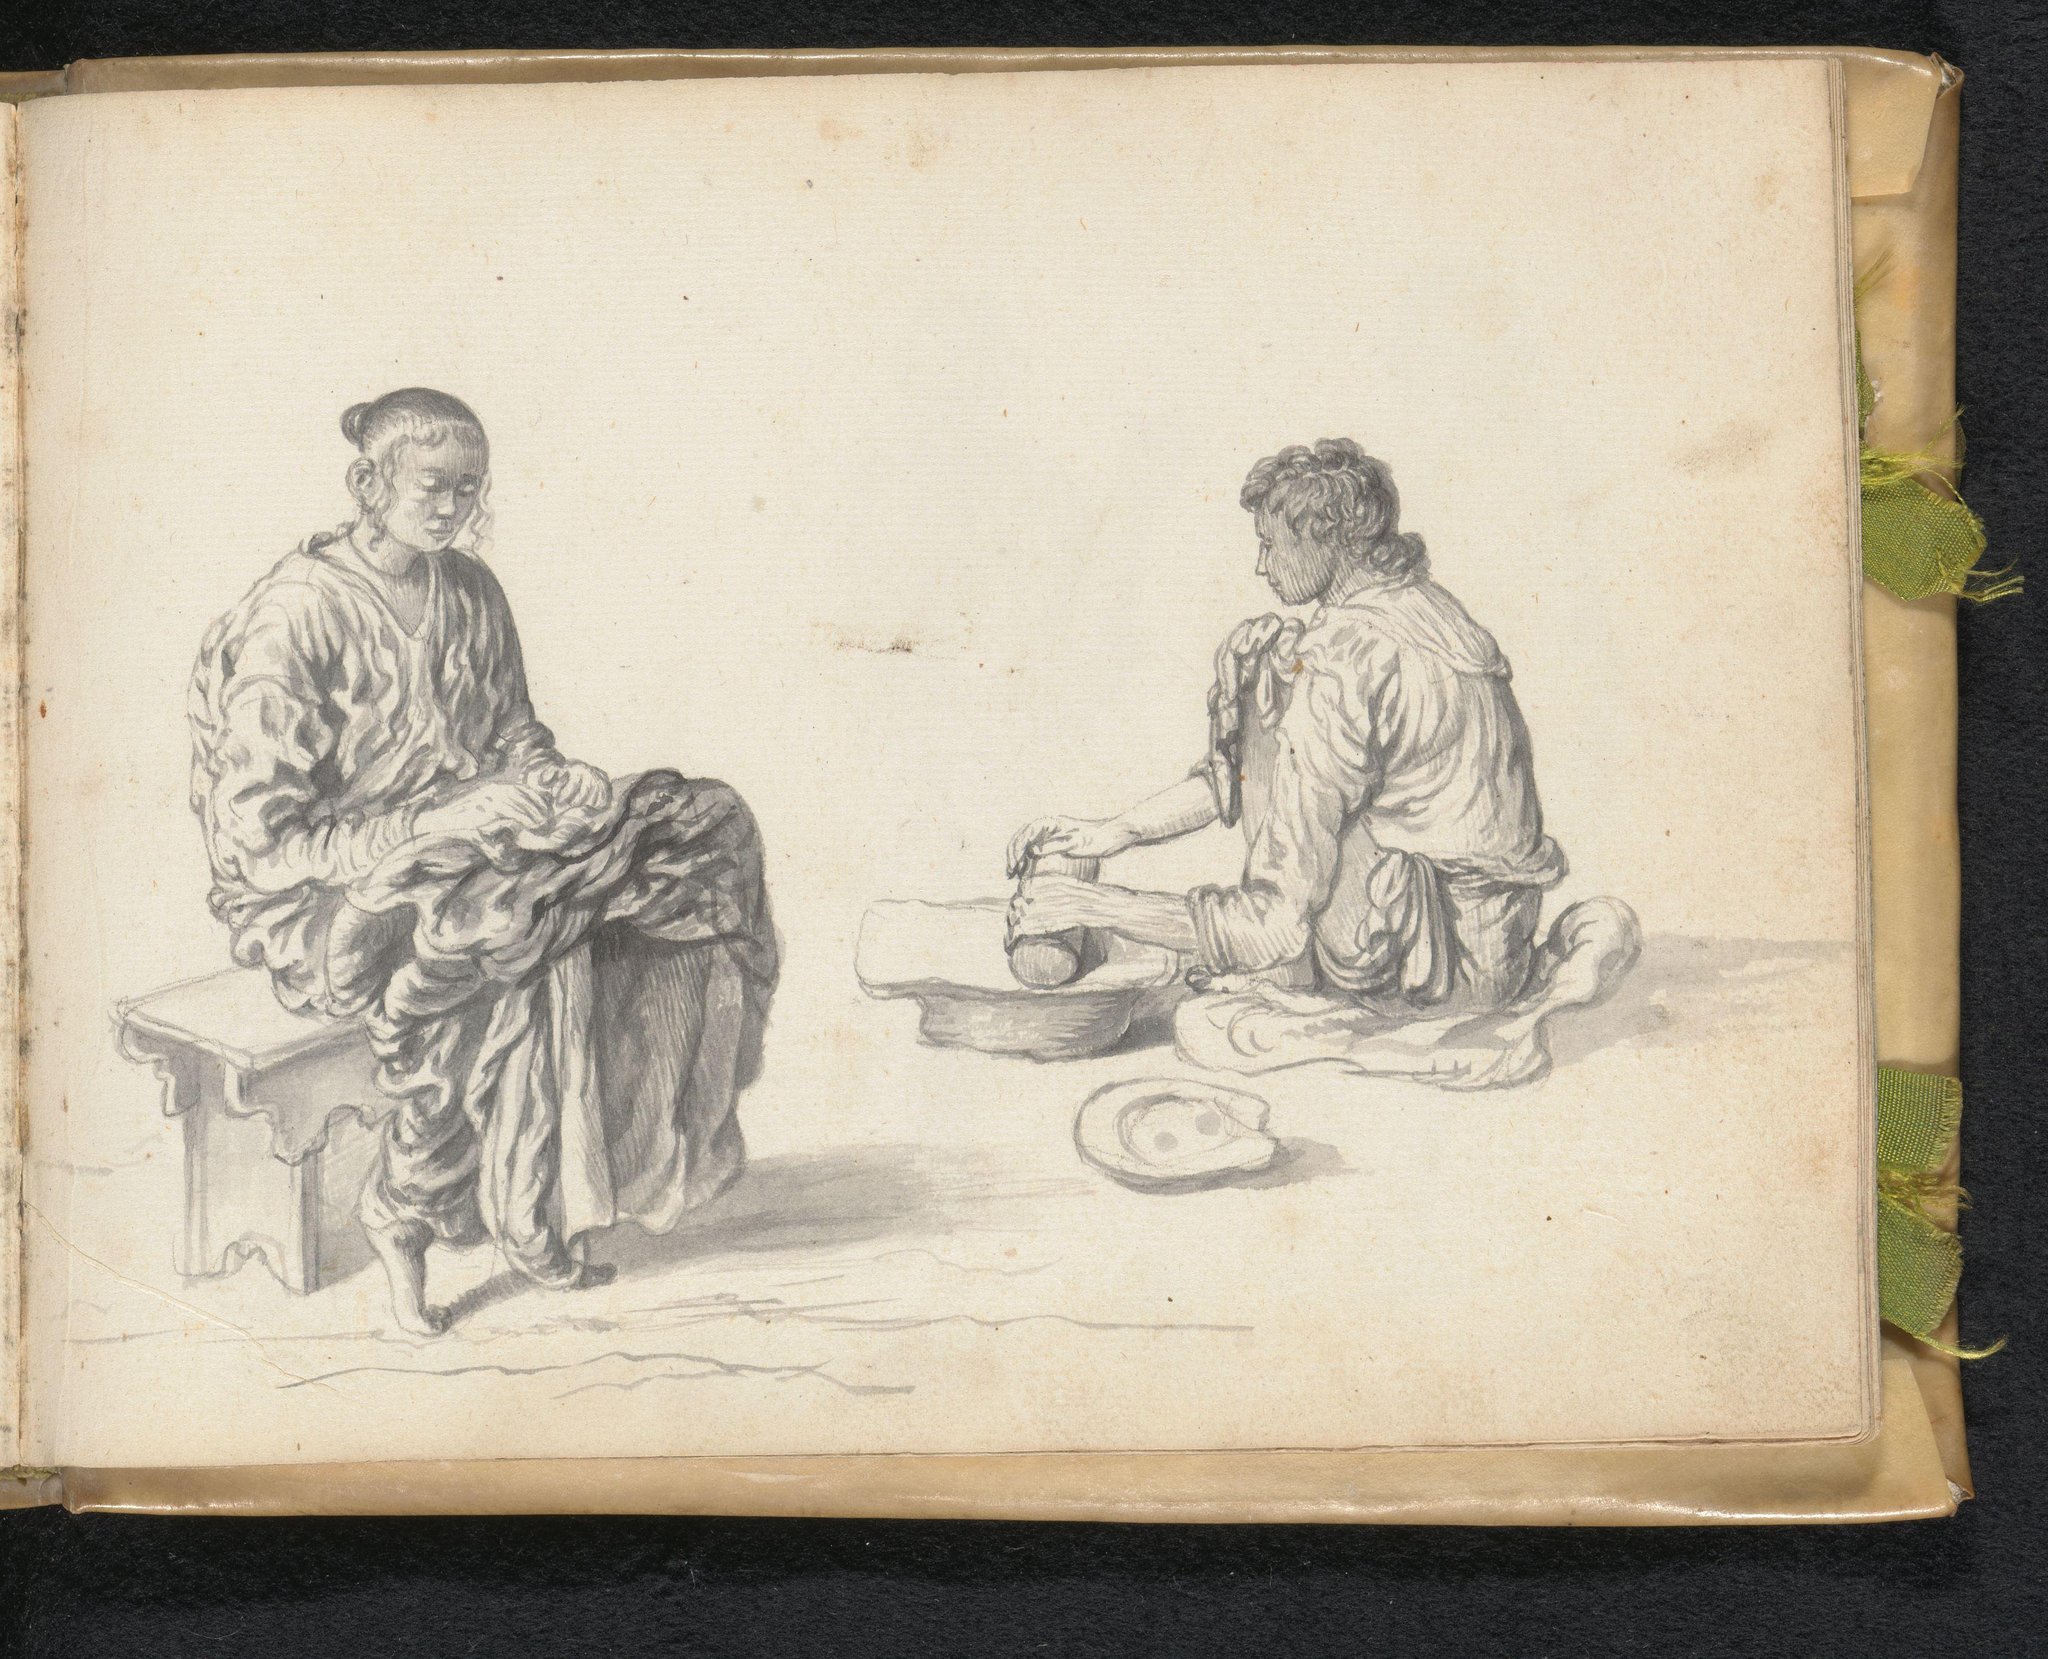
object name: sketchbook leaf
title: Two Eurasian women doing domestic work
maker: esaias boursse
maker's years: 1631-1672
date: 1662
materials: ink, paper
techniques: brush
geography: sri lanka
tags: preparing dough or batter, eurasion, half-caste, skirt (with name), clothing for the upper part of the body (with name), styles of hairdress (with name) - ~women, sewing, sri lanka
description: Binnen in huis of op een binnenplaats zijn twee Euraziatische vrouwen geconcentreerd aan het werk. Links op een houten bankje zit een vrouw gekleed in een lange wikkelrok (redda) en een Portugese bloes met V-hals en lange mouwen (hatte). Ze draagt het haar naar achter gekamd in een wrong (condé), met losse lokken langs haar wangen. Om haar hals lijkt een kettinkje te zijn getekend. Haar beide handen liggen met gebogen vingers naast elkaar op een grote verfrommelde lap stof op haar schoot. Haar voorover gebogen hoofd en haar blik zijn er ook op gericht. Misschien is ze aan het naaien. Rechts op een lap stof zit de andere vrouw gehurkt achter een platte steen waar ze met beide handen met een stenen roller deeg uitrolt. Ze draagt een Portugese bloes met lange mouwen (hatte) en een hoog tot boven de knieën opgetrokken wikkelrok (redda). Op de grond naast haar staat een schaal met, waarschijnlijk, een plak deeg. Blad 108 uit een schetsboek met 117 bladen.